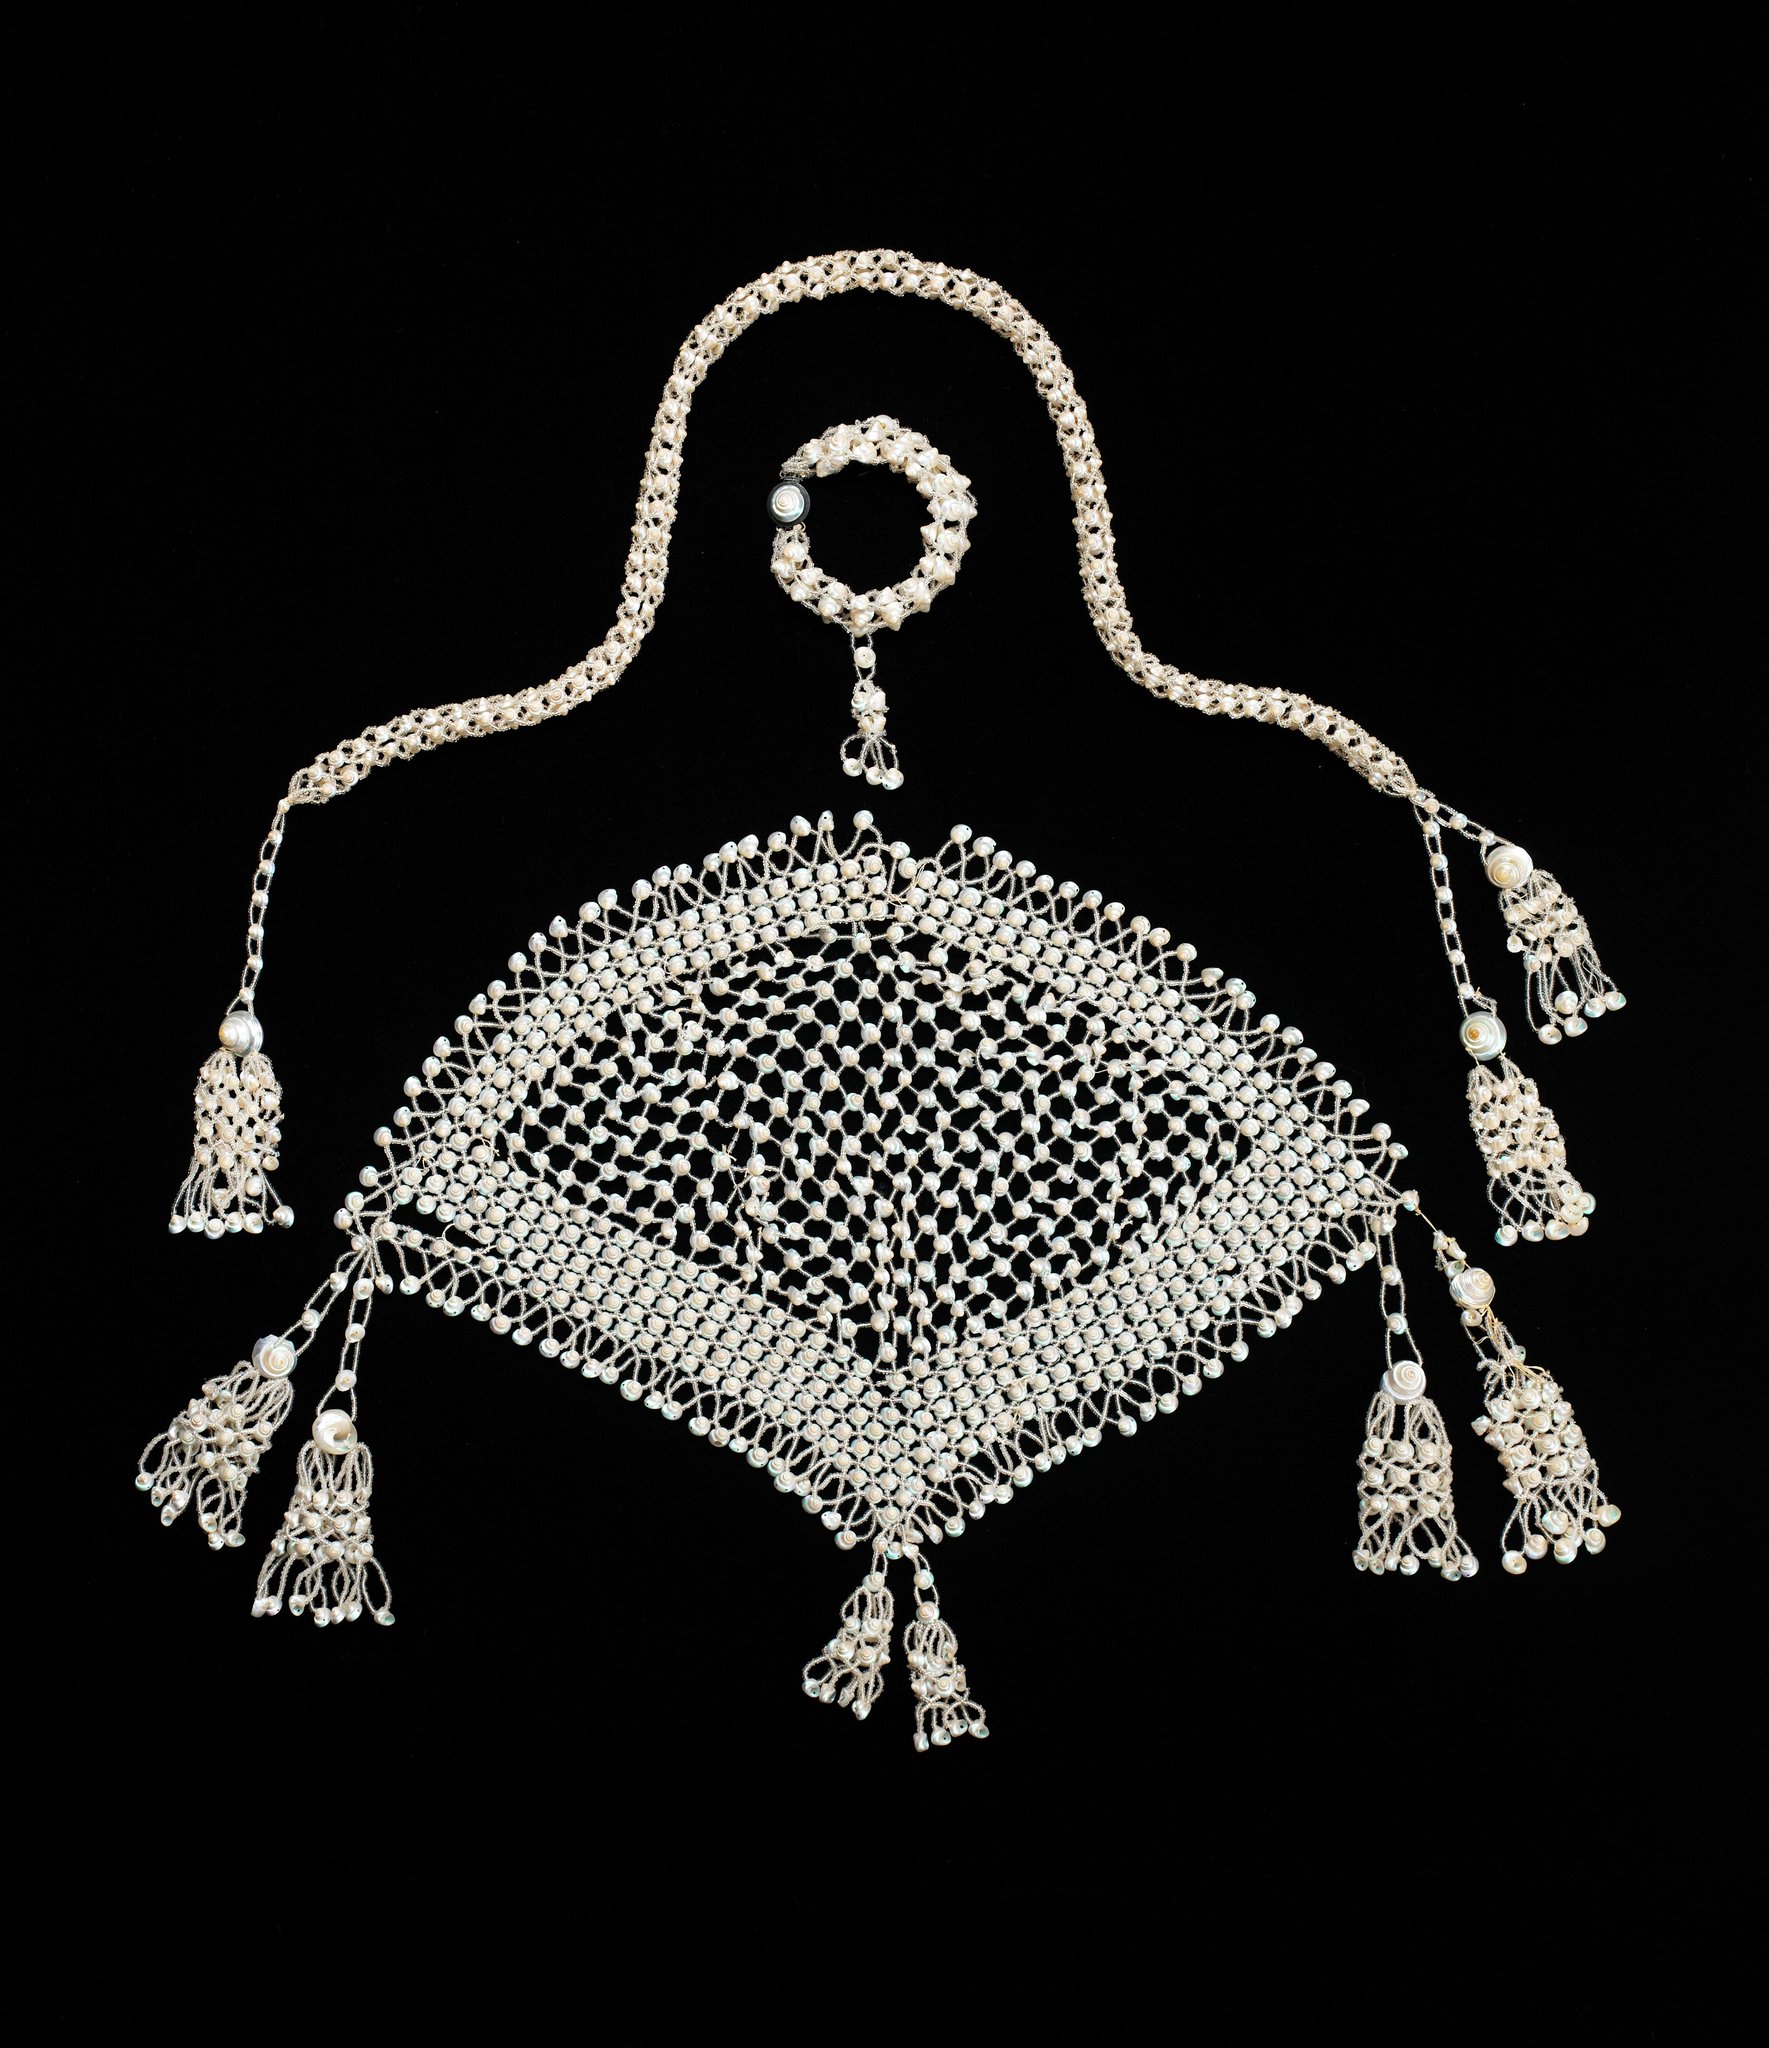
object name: accessory set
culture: american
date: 1860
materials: shell